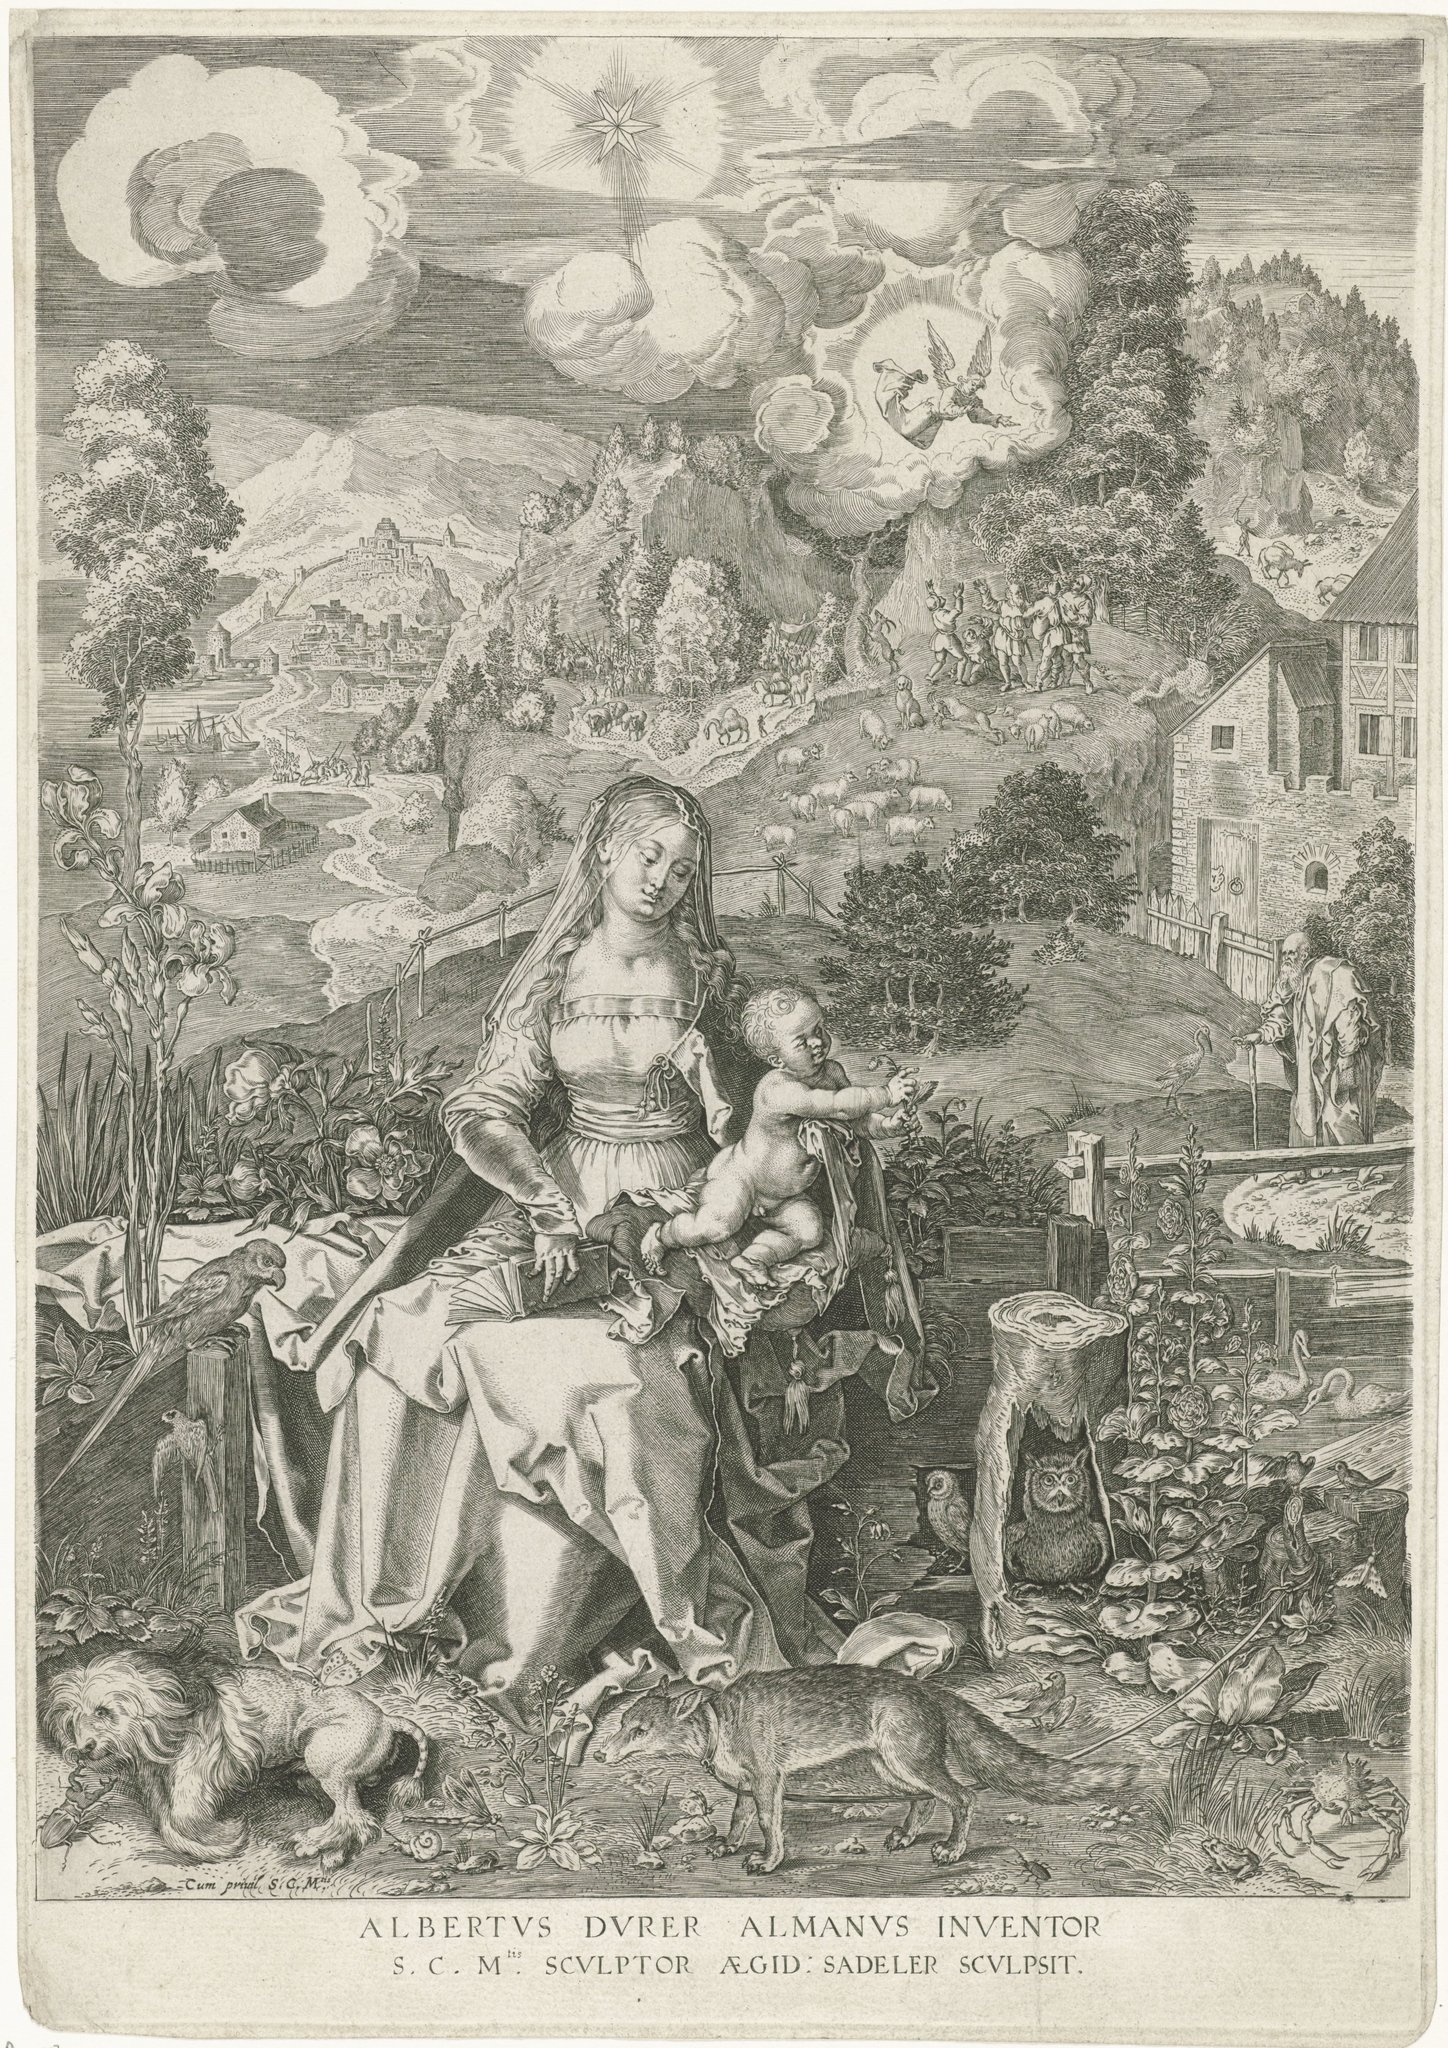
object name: print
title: Maria met kind in een landschap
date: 1580-1629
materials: paper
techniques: engraving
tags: madonna: i.e. mary with the christ-child, annunciation of christ's birth to the shepherds (and/or shepherdesses) at night; a host of singing angels in the air, owls, crustaceans: crab, dog, beasts of prey, predatory animals: fox, mountains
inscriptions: collector's mark: Lugt 2228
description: Maria met het Christuskind op haar schoot. Op de achtergrond een berglandschap met een engel die de geboorte van Christus verkondigt aan een groep herders. Op de voorgrond allerlei dieren.